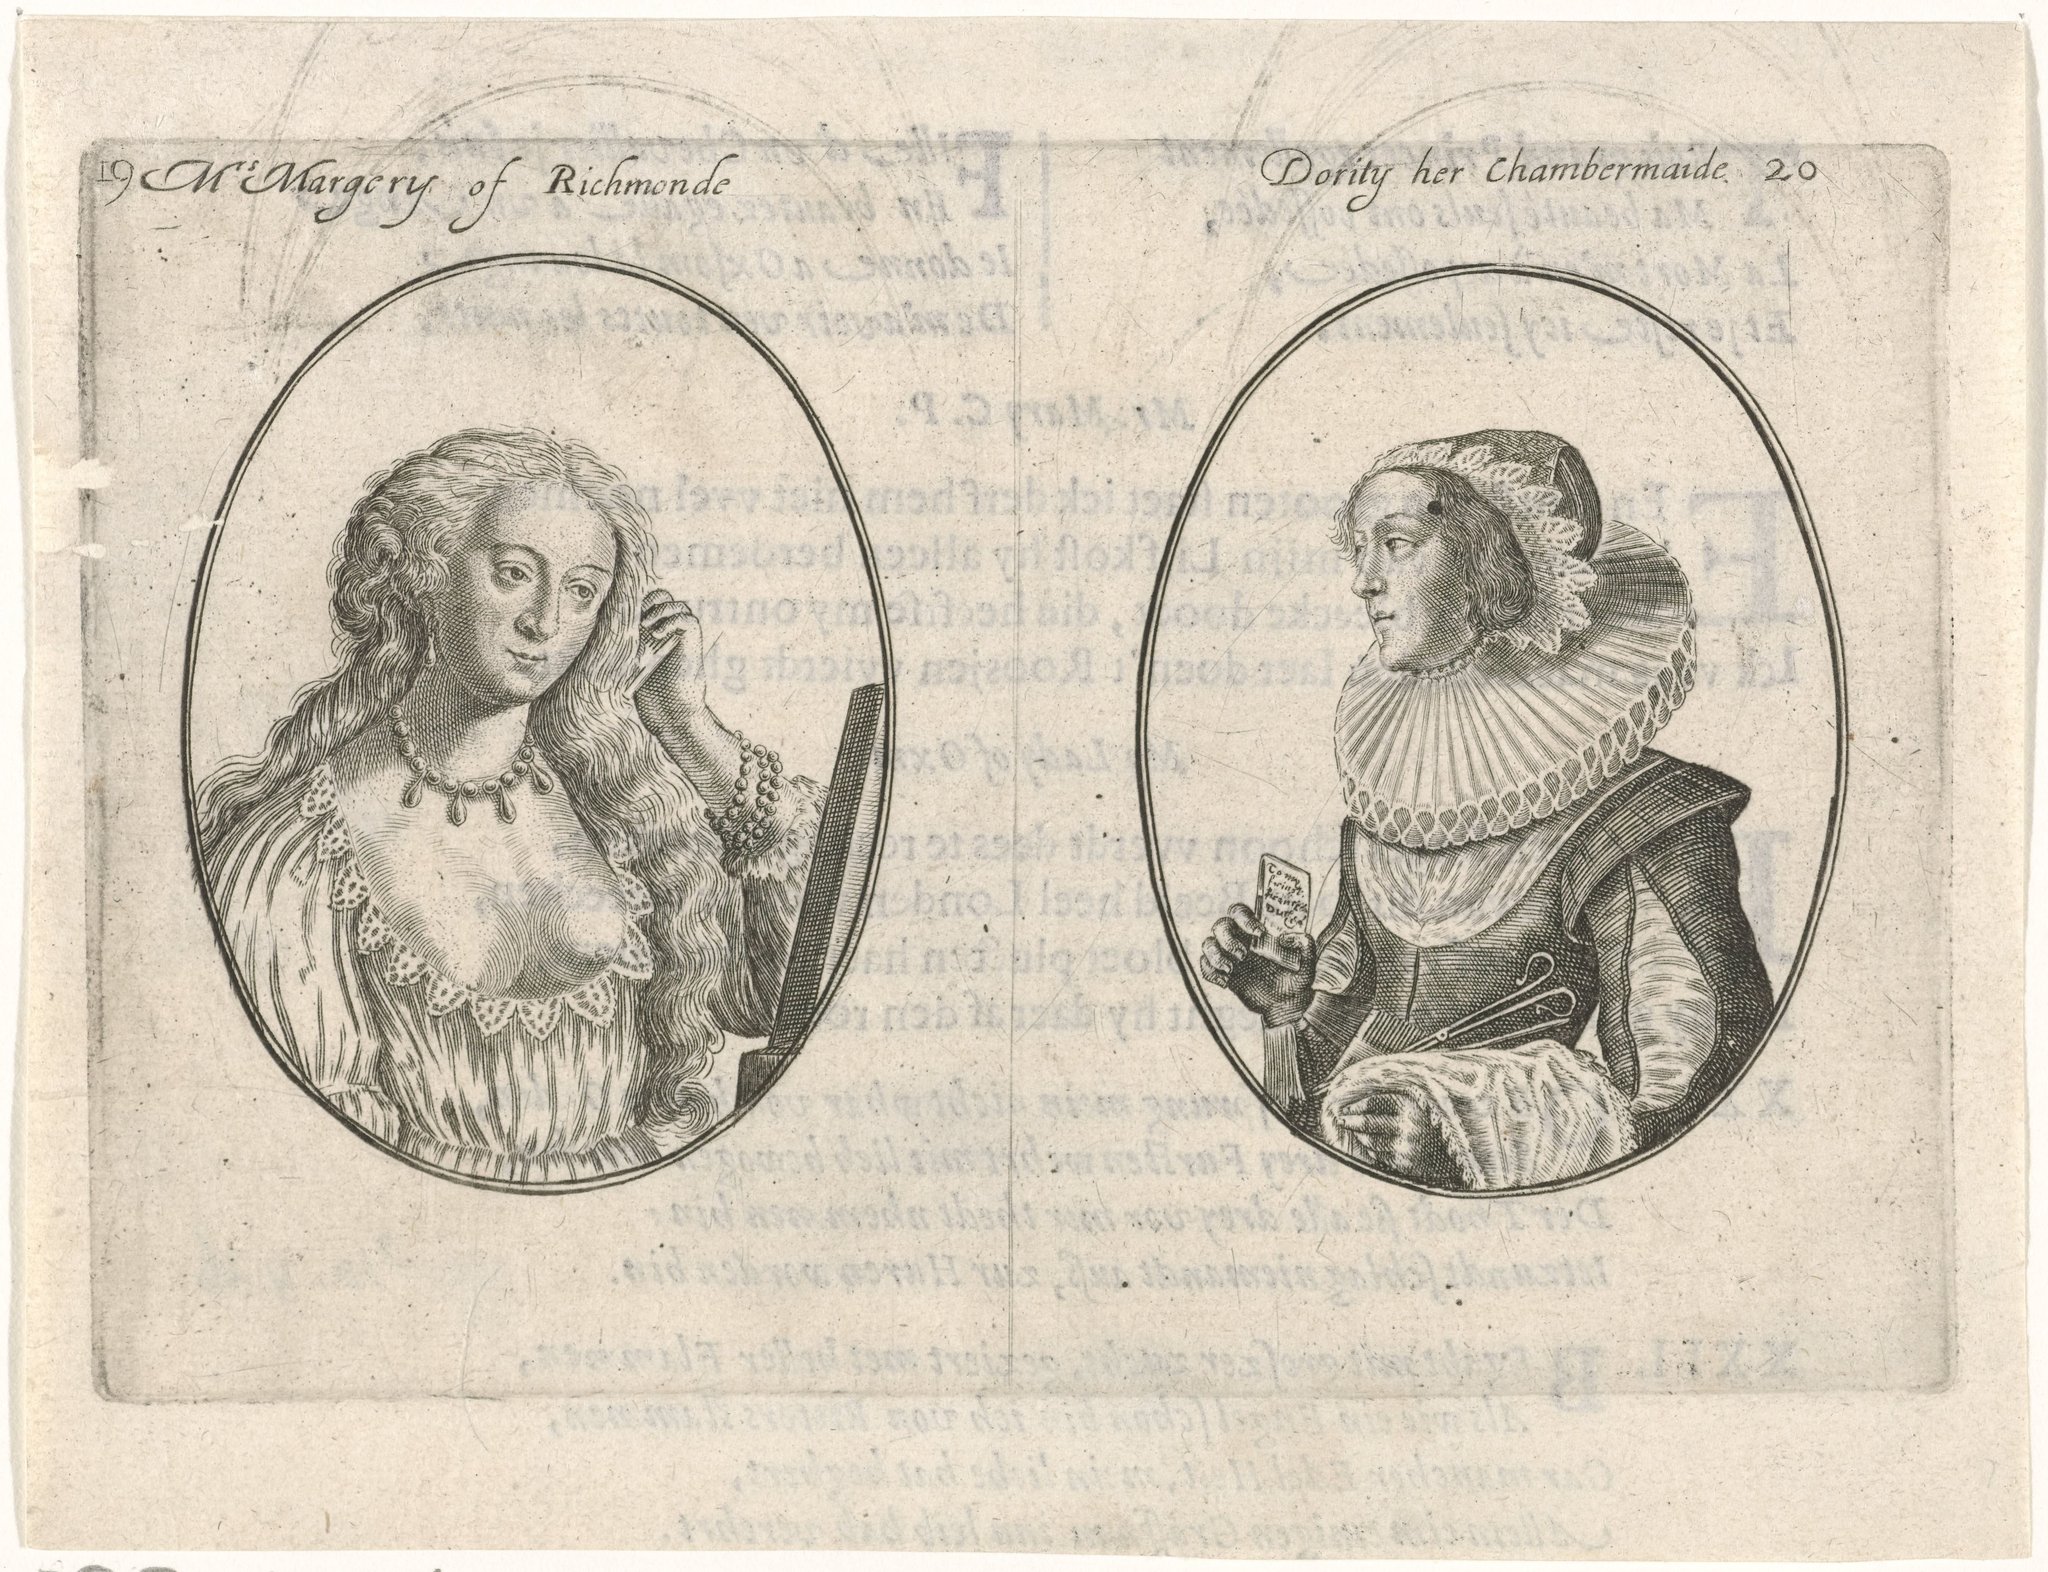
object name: costume print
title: Portretten van een courtisane en haar kamermeid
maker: crispijn van de passe (ii)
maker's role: draughtsman, print maker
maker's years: 1594-1670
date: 1630-1632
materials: paper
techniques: engraving, letterpress printing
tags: whore, prostitute - cc - male prostitution, servant - aa - chambermaid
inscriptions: collector's mark: Lugt 2228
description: Prent gemaakt voor: Le miroir des courtisannes de ce temps. Verschillende edities van dit werk, uitgegeven tussen 1630 en 1710, maken gebruik van de gravures van Van der Passe óf van spiegelbeeldige kopieën ervan.